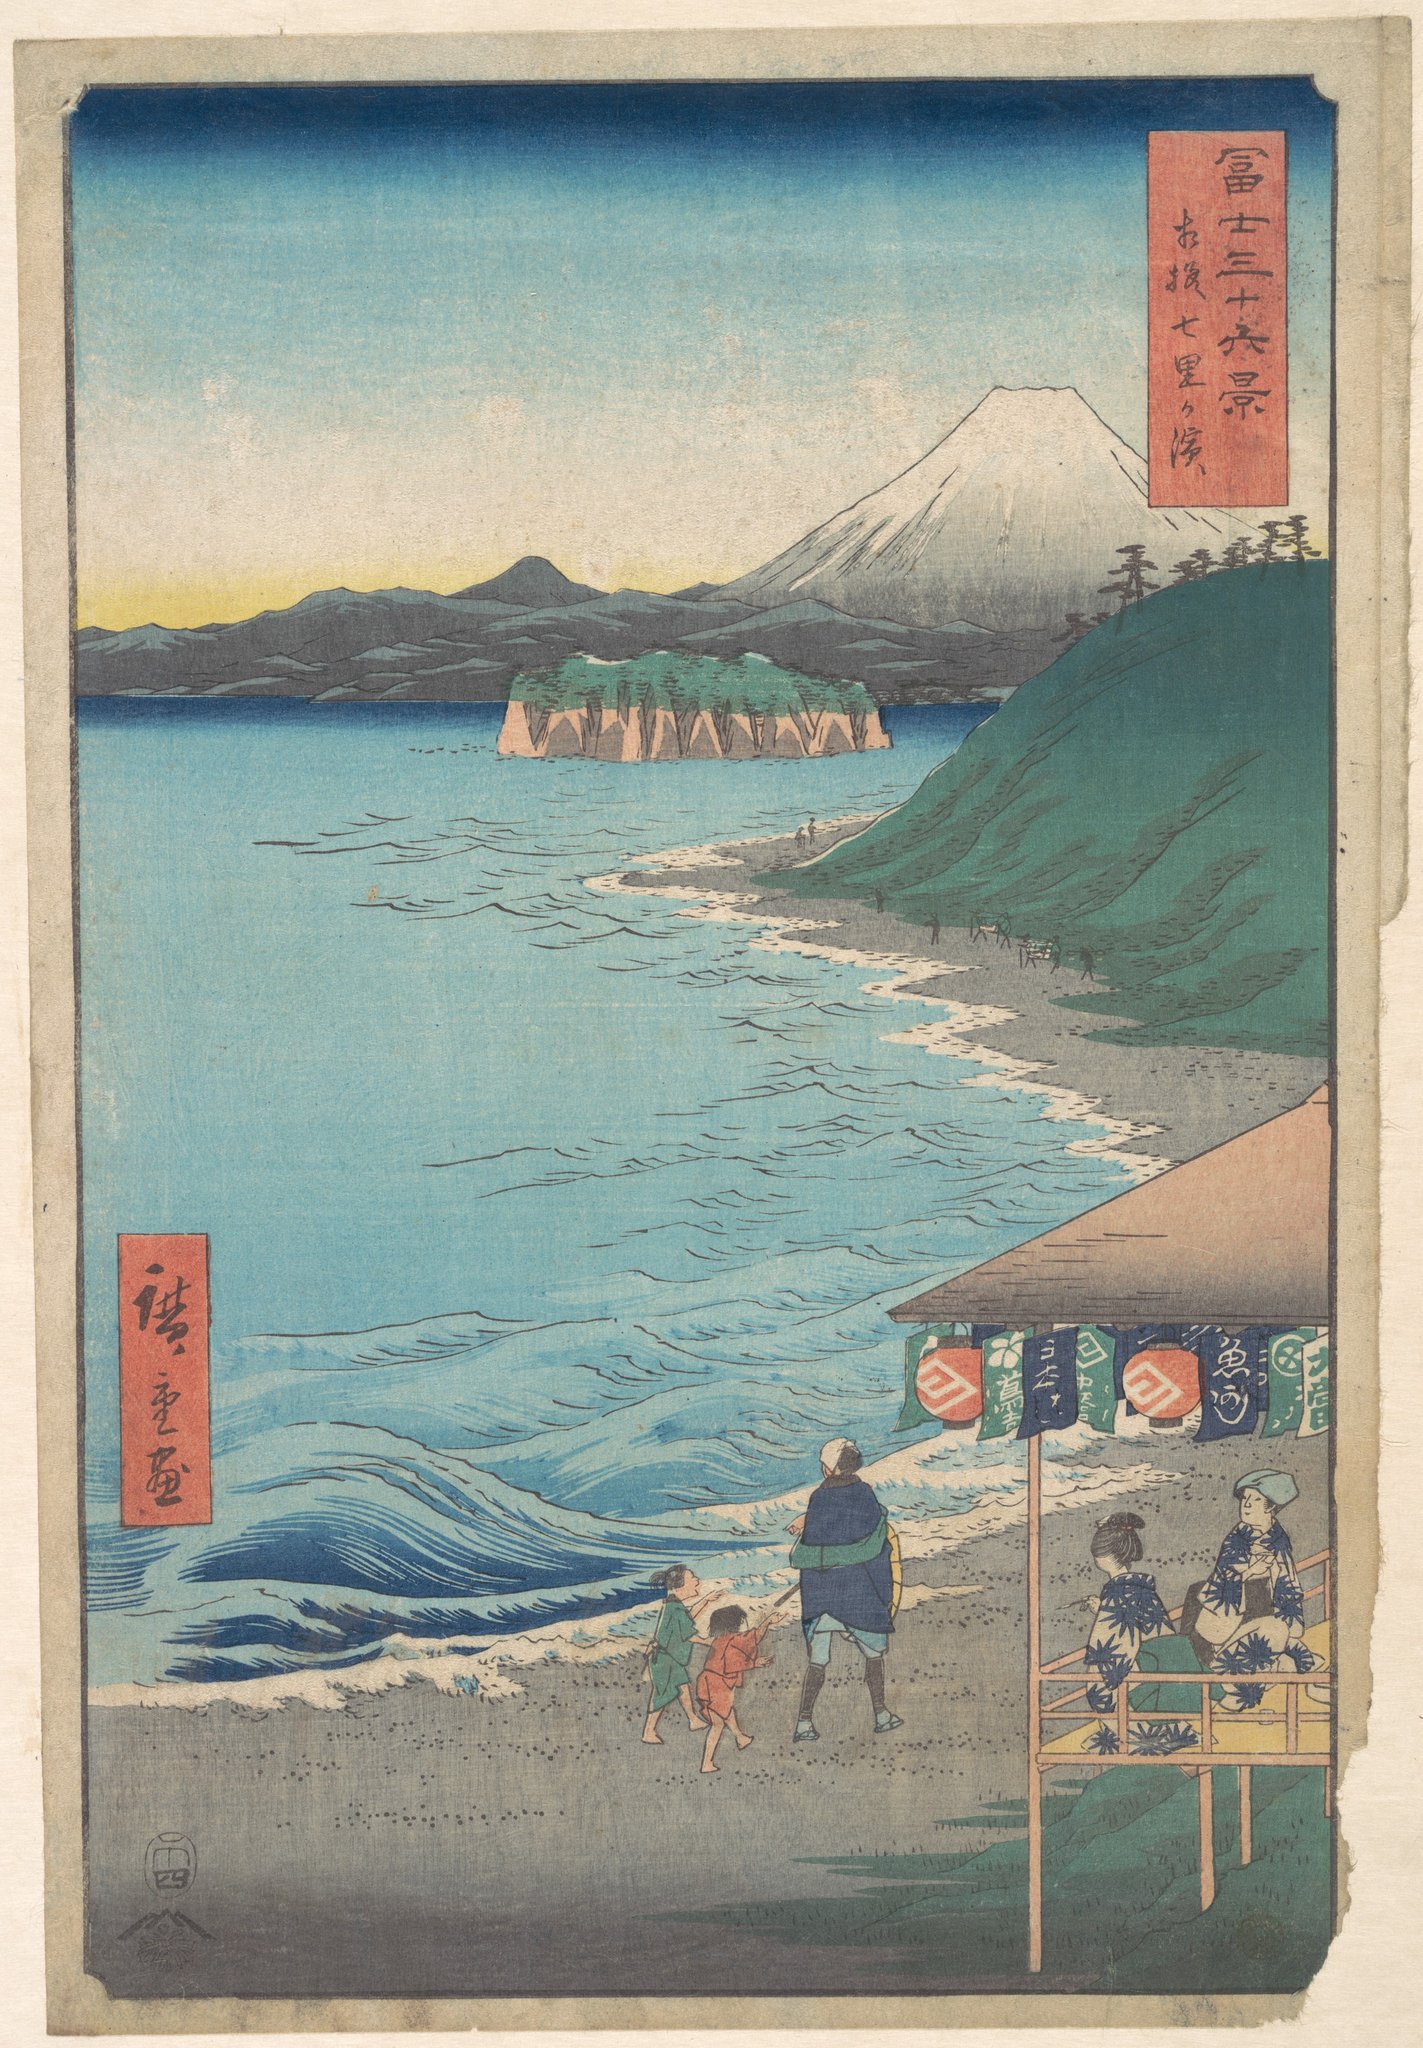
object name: print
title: View of Mount Fuji from Seven-ri Beach, Province of Sagami (Sōshū: Shichi-ri ga hama), from the series Thirty-six Views of Mount Fuji (Fugaku sanjūrokkei)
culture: japanese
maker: utagawa hiroshige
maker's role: artist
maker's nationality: japanese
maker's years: 1797-1858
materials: ink, paper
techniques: woodblock print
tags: human figures,beaches,mountains